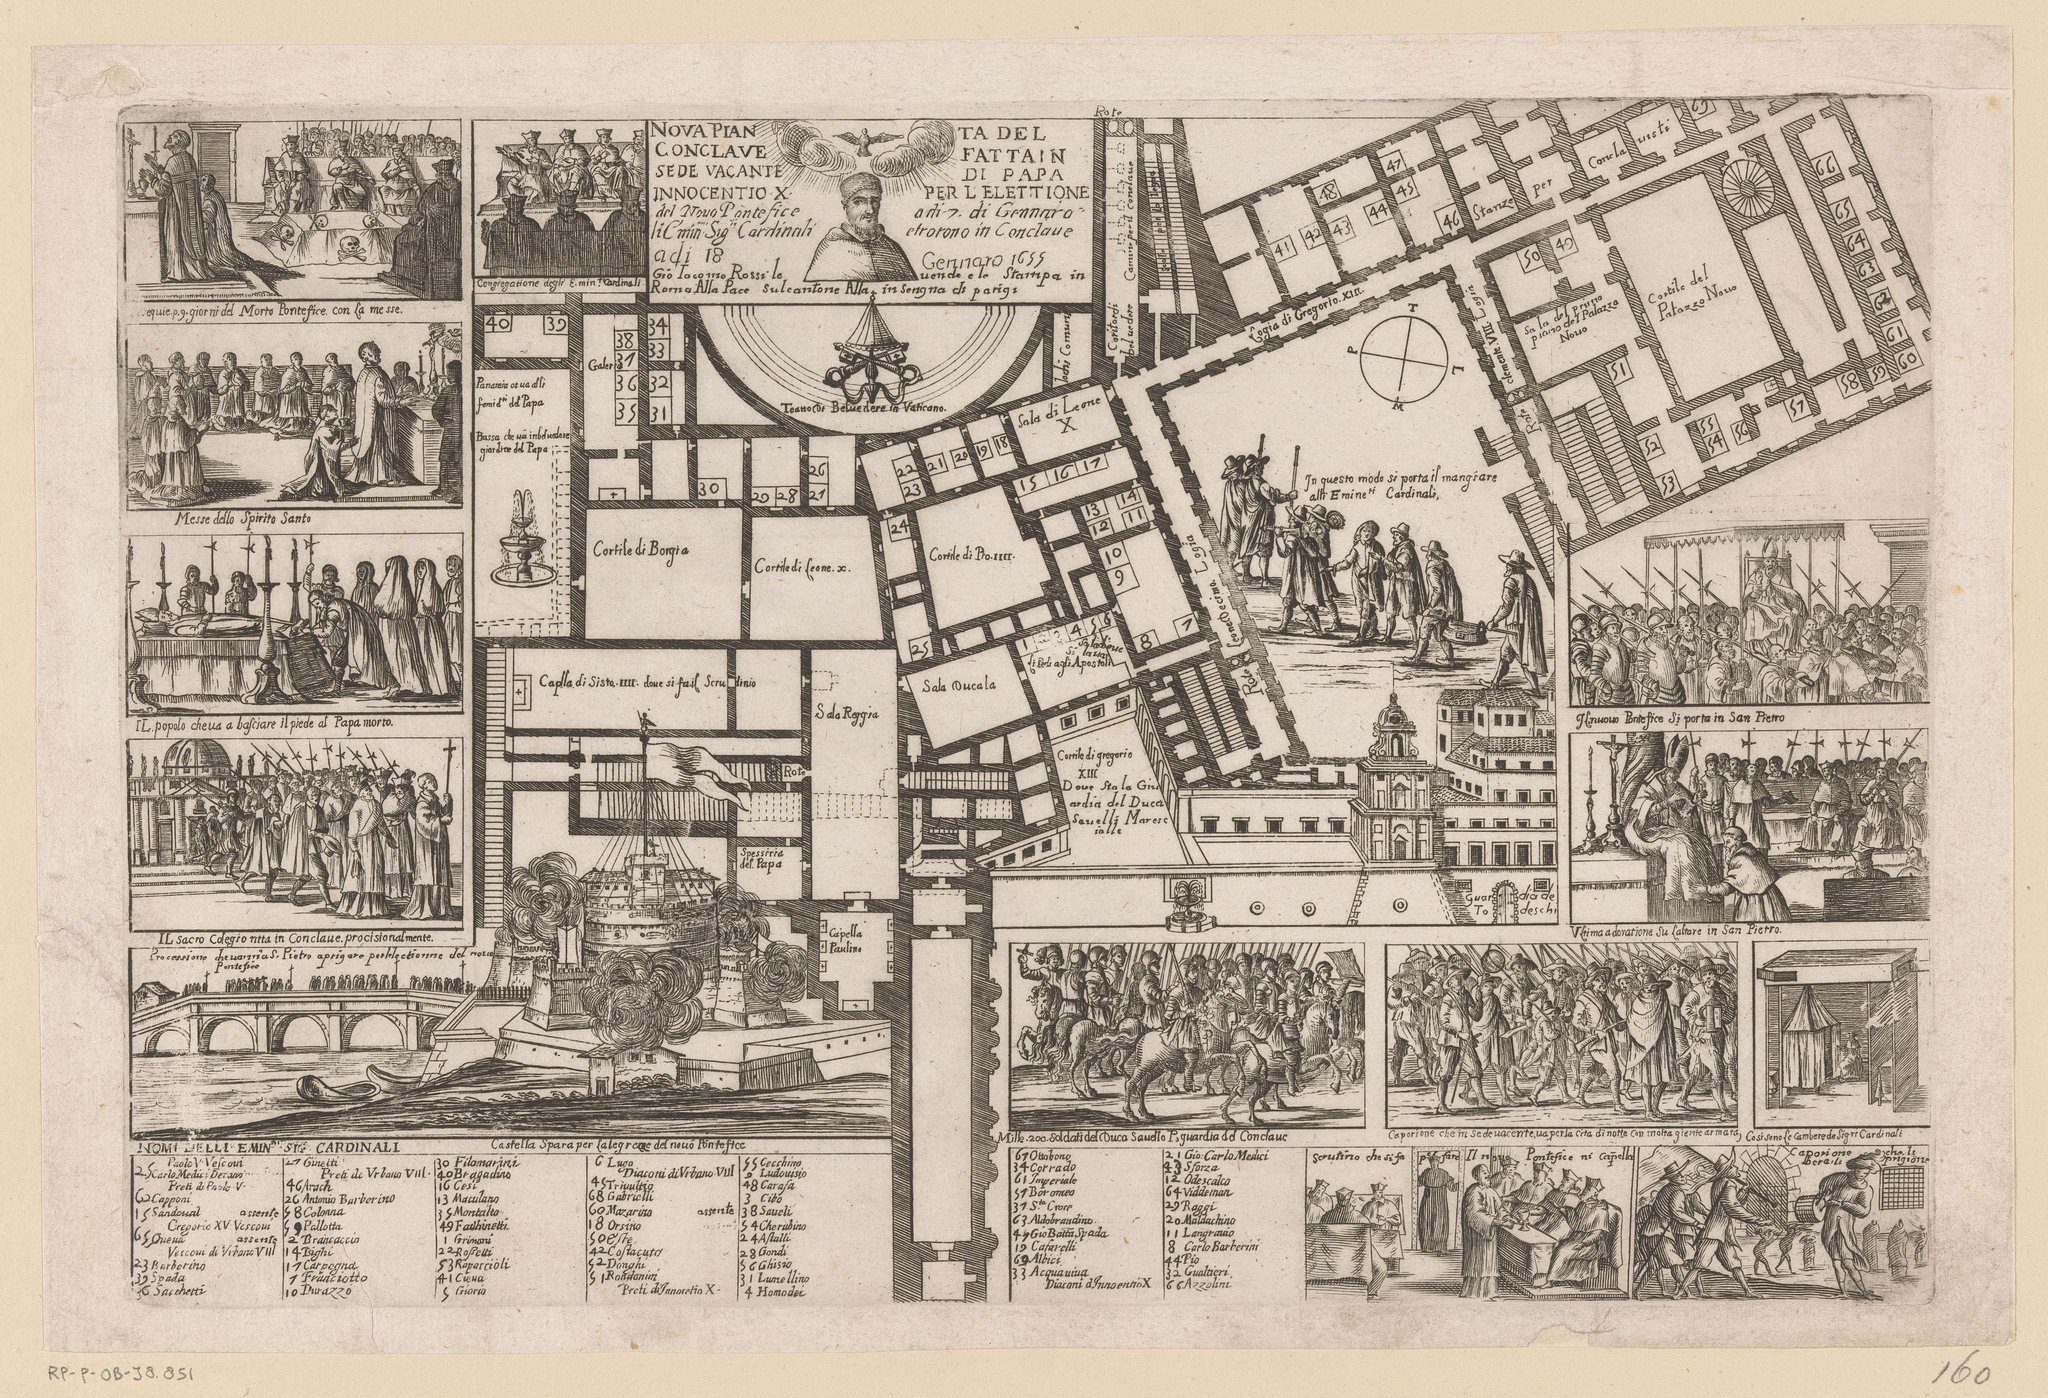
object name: print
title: Conclaaf na het overlijden van Innocentius X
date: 1655-1657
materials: paper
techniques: engraving, etching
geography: rome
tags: alexander vii, innocentius x, conclave ~ roman catholic church, plan ~ architecture, pope, rome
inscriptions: collector's mark: Lugt 240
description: Verschillende scènes rondom het overlijden van paus Innocentius X en het conclaaf ter verkiezing van zijn opvolger paus Alexander VII.